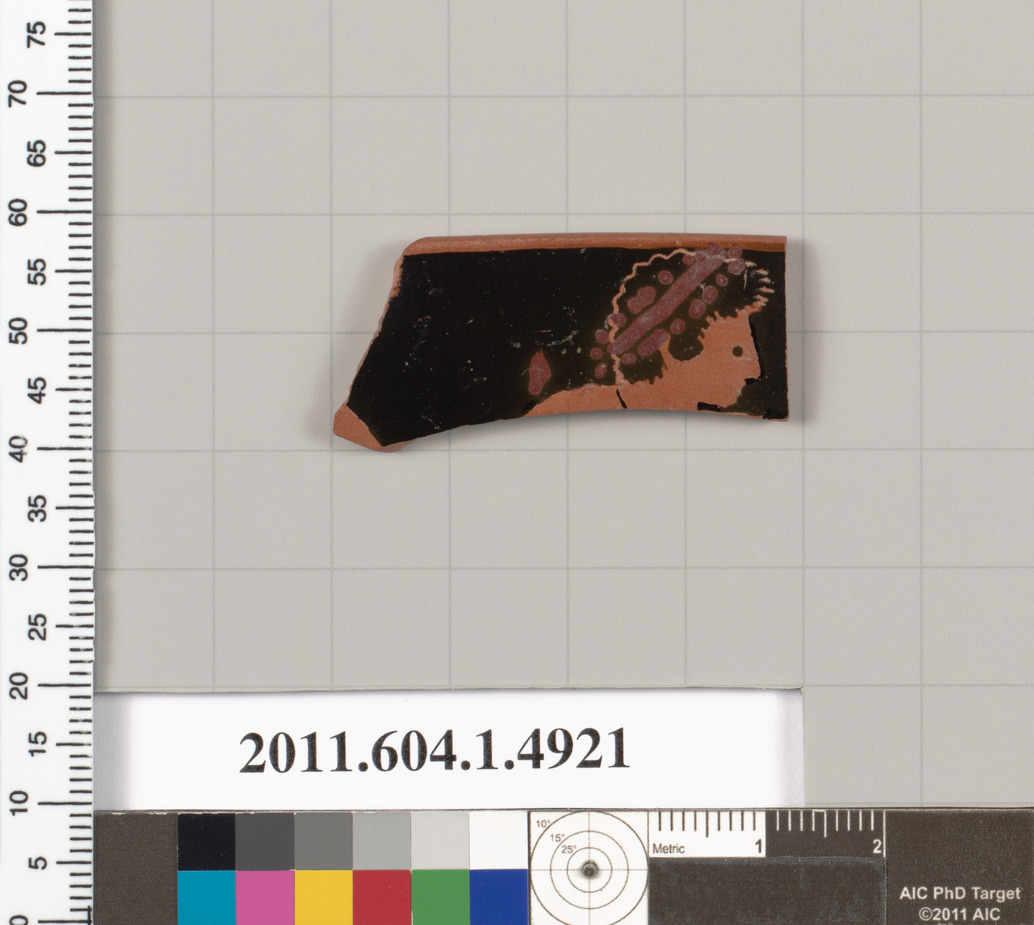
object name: kylix fragment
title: Terracotta rim fragment of a kylix (drinking cup)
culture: greek, attic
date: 520-500 BCE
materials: terracotta